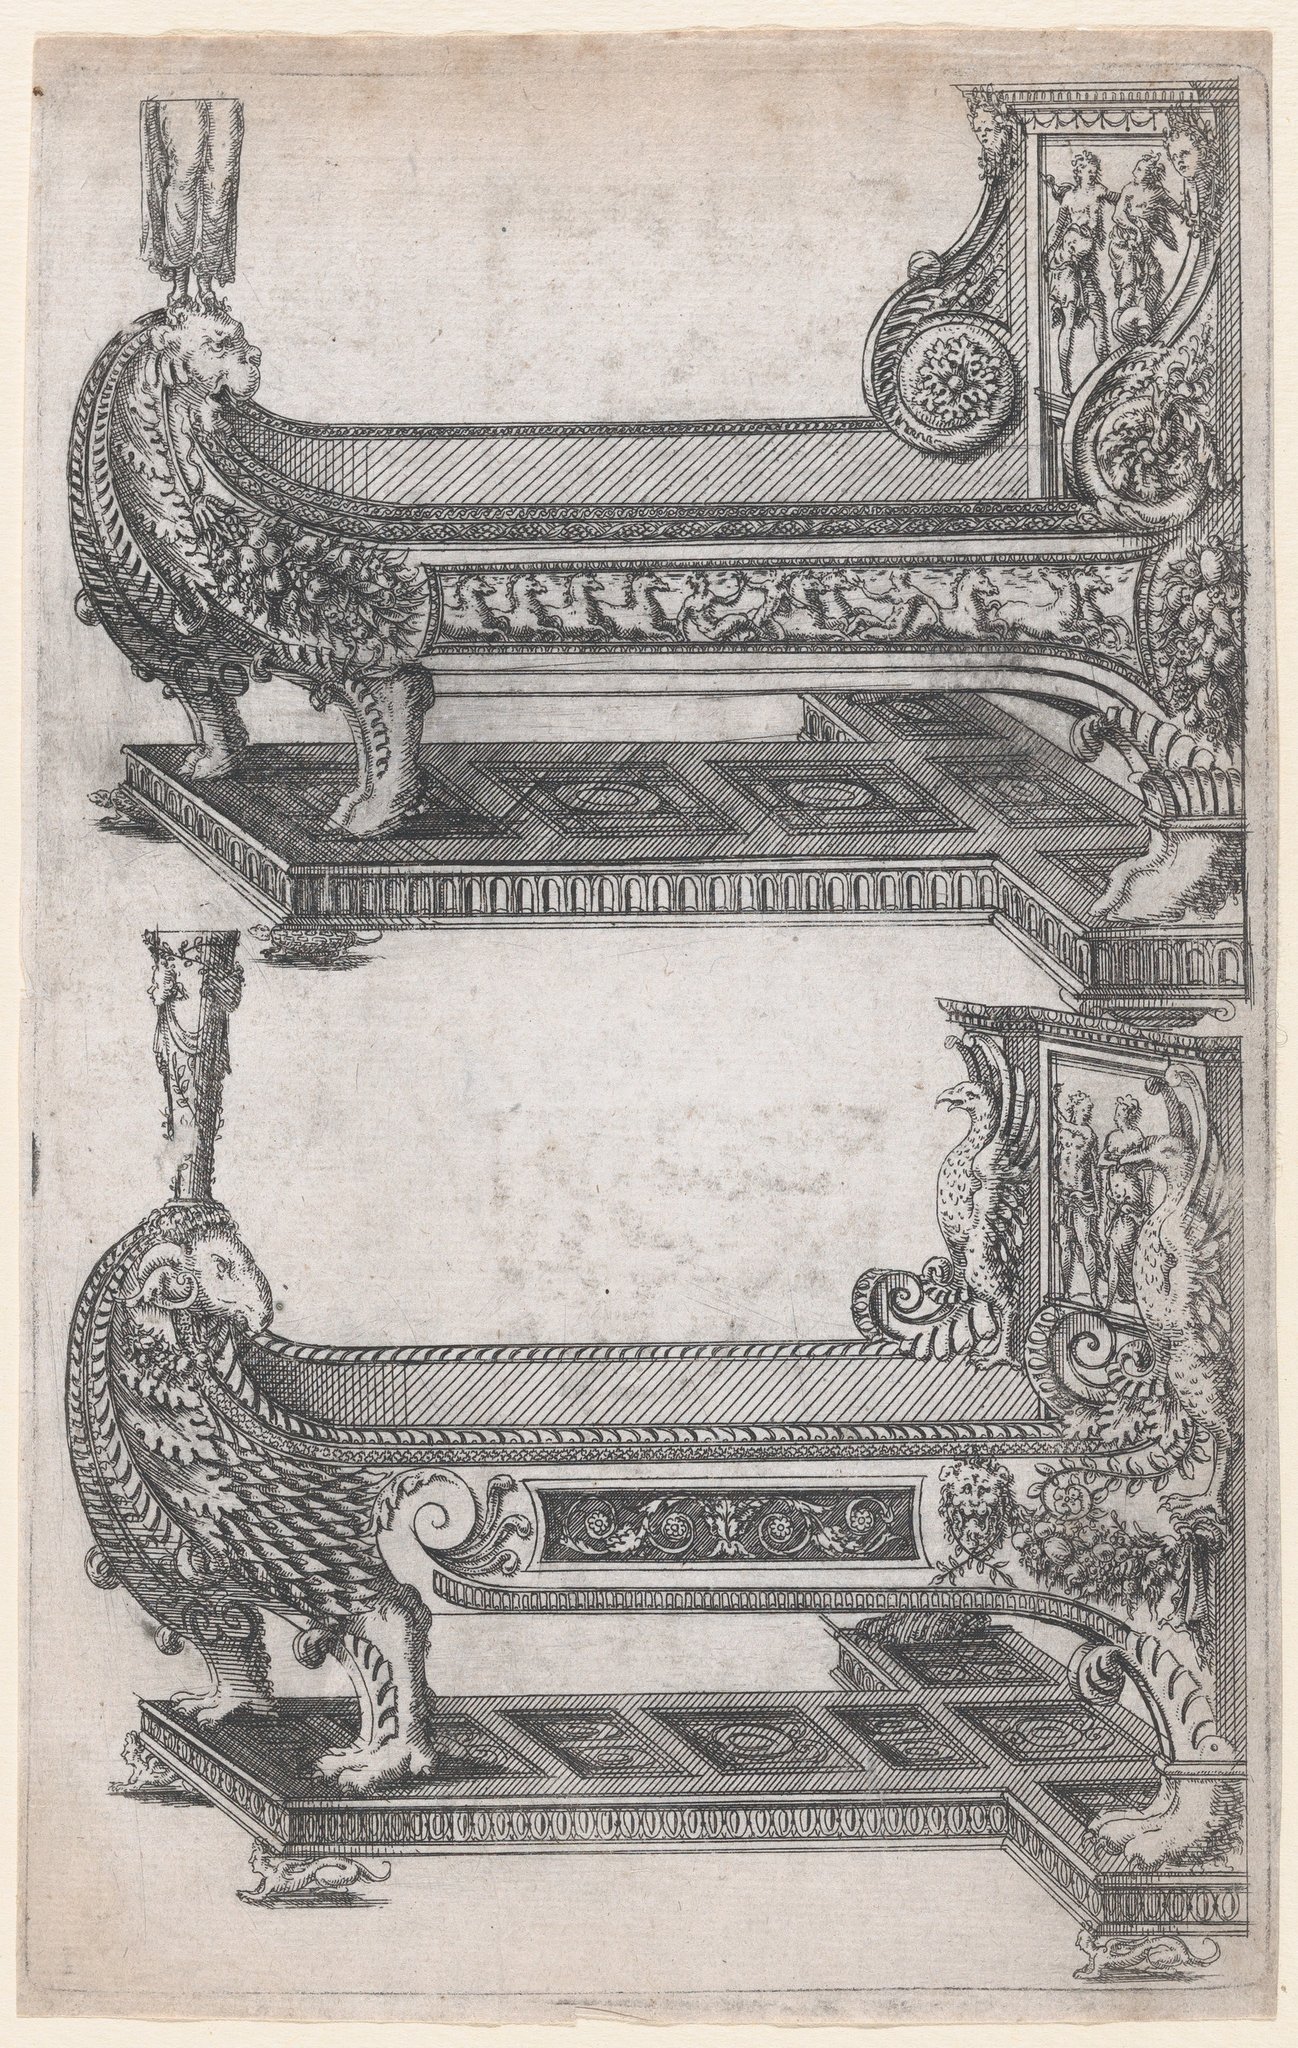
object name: print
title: Designs for Two Beds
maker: jacques androuet du cerceau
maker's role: artist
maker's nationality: french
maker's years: 1510-1585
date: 1565-1570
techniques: etching